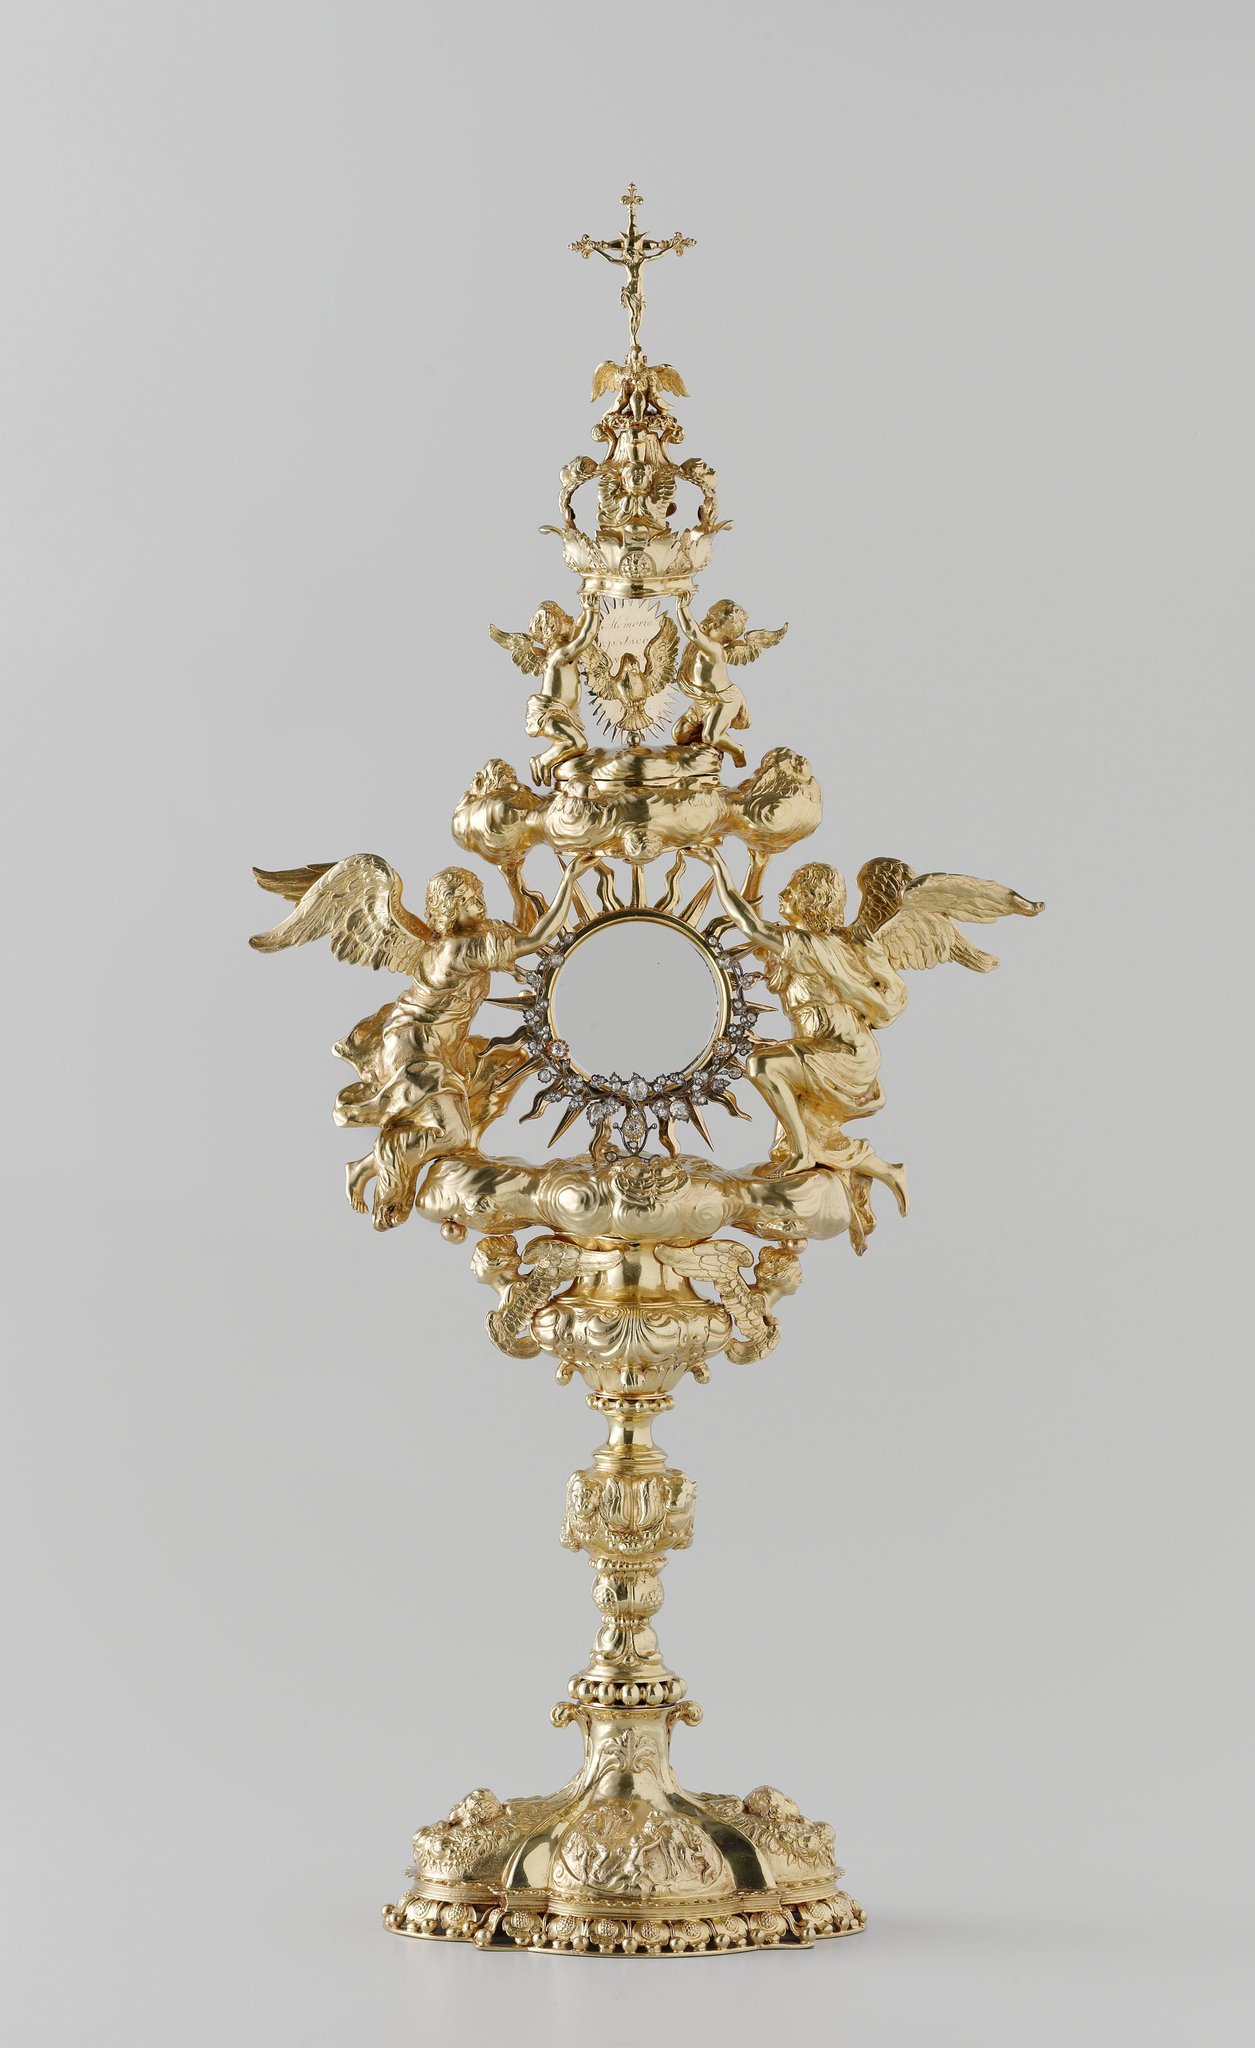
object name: monstrans, ostensorium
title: Monstrance from De Toren clandestine church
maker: Anonymous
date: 1675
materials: diamond, glass, gold, silver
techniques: gilding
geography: antwerp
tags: altarcross, crucifix, angels, holy ghost represented as a dove (in flames)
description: Roman Catholics believe that the consecrated bread is literally the body of Christ. The Host thus became an object of veneration, and containers were made in which to keep or display it to the faithful. The monstrance (from the Latin word for ‘to show’) is the most important of all of the Host containers, as is underscored by its sculptural design and the precious materials used to make it.